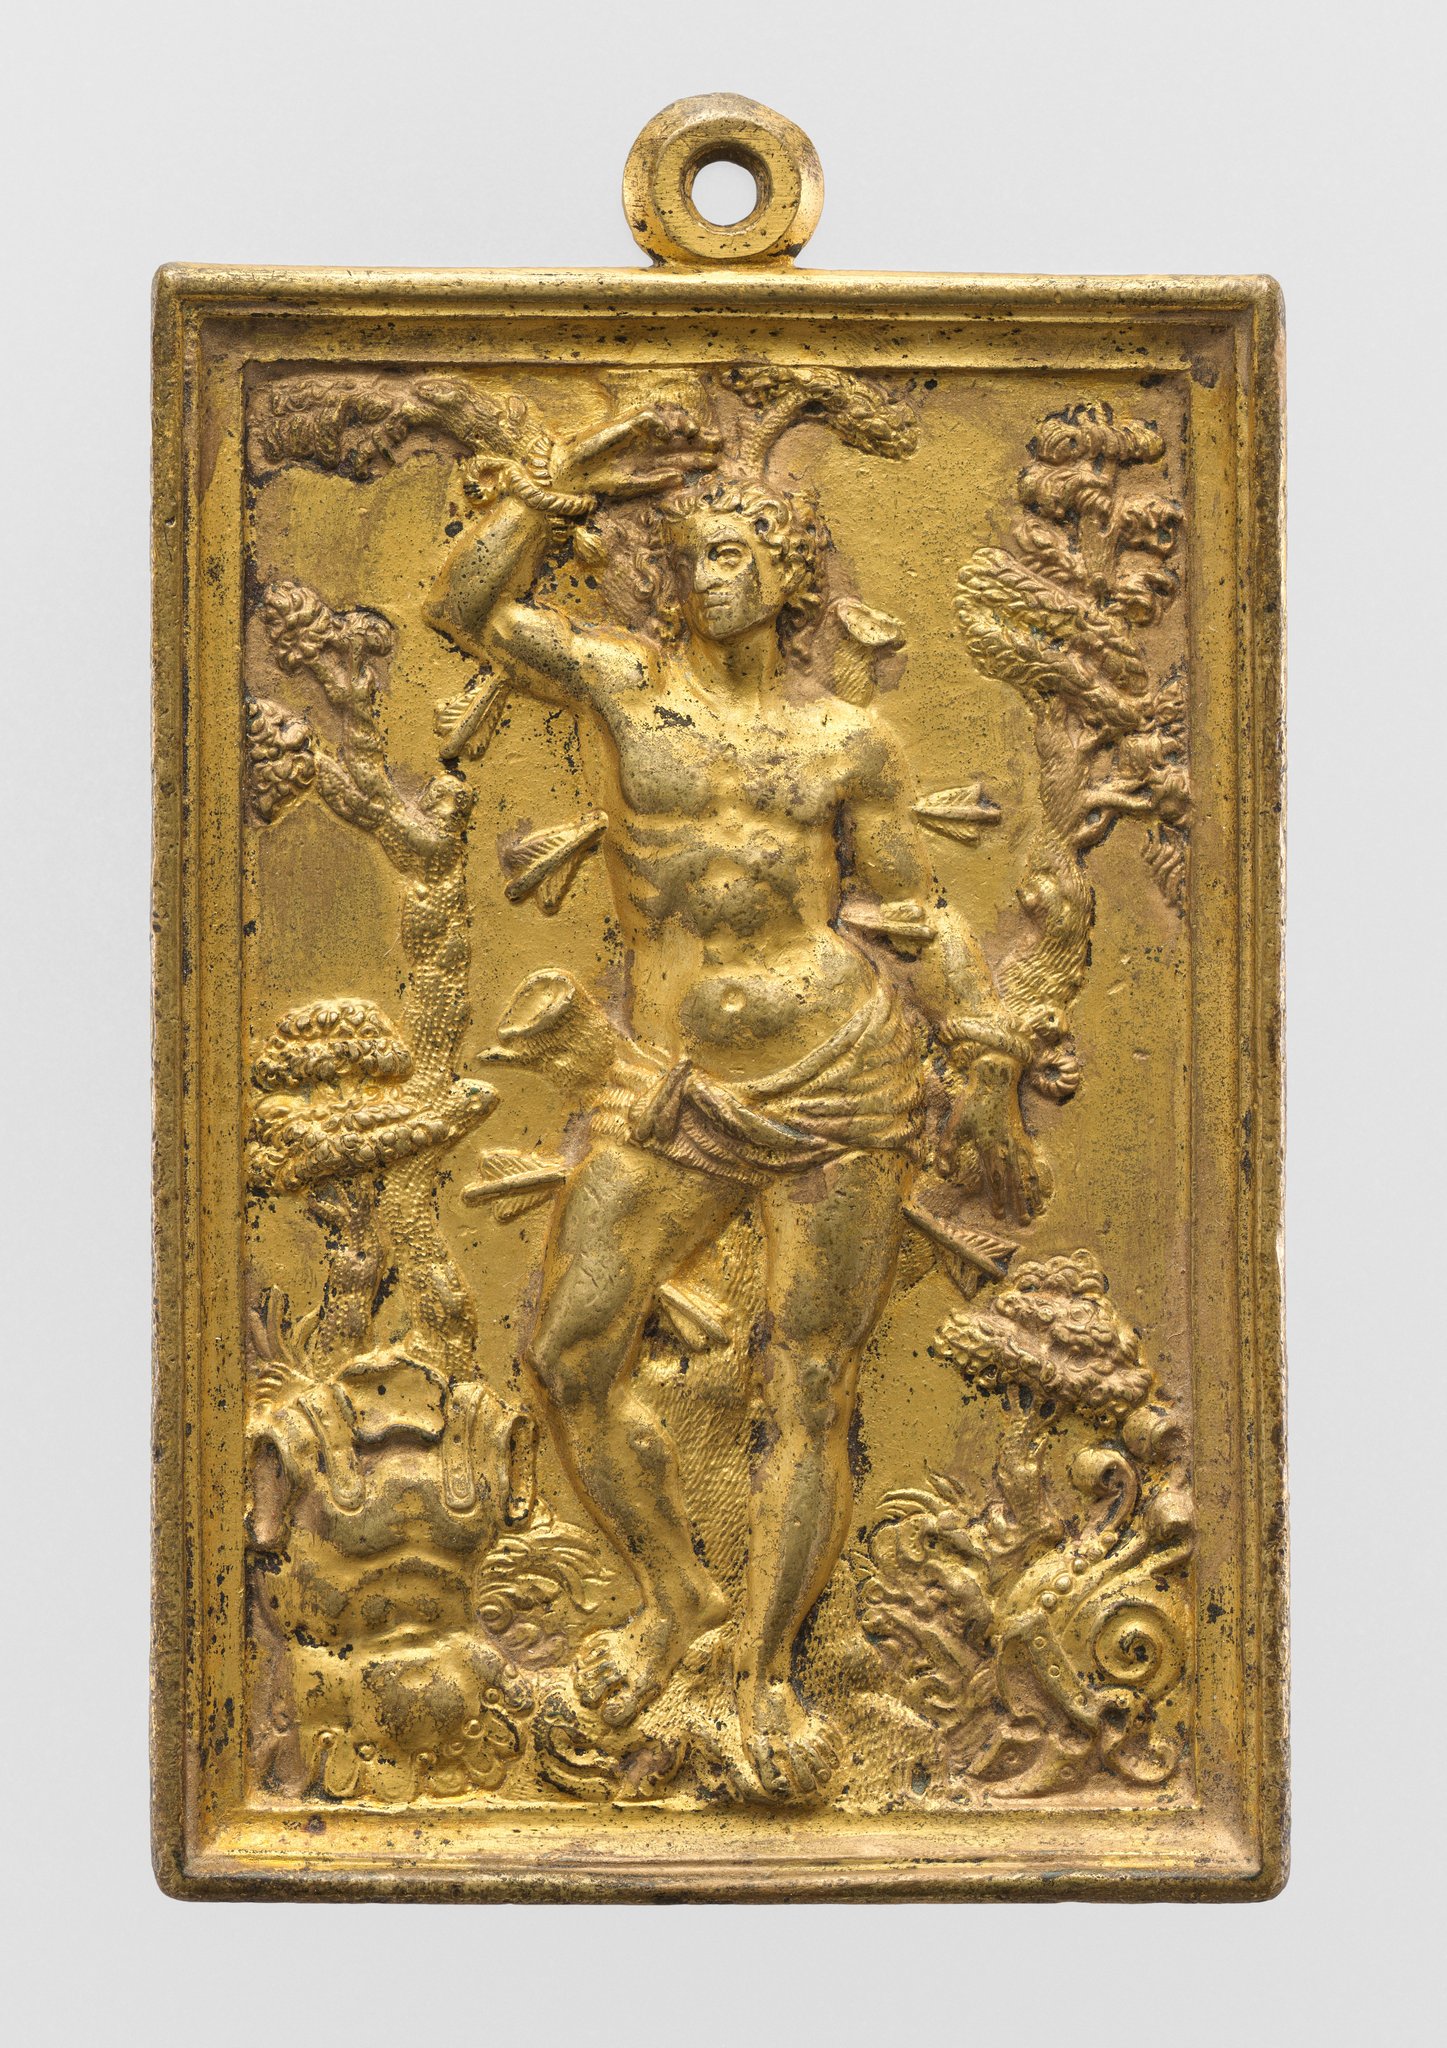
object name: plaquette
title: Saint Sebastian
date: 1601-1633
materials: gilt bronze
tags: saint sebastian